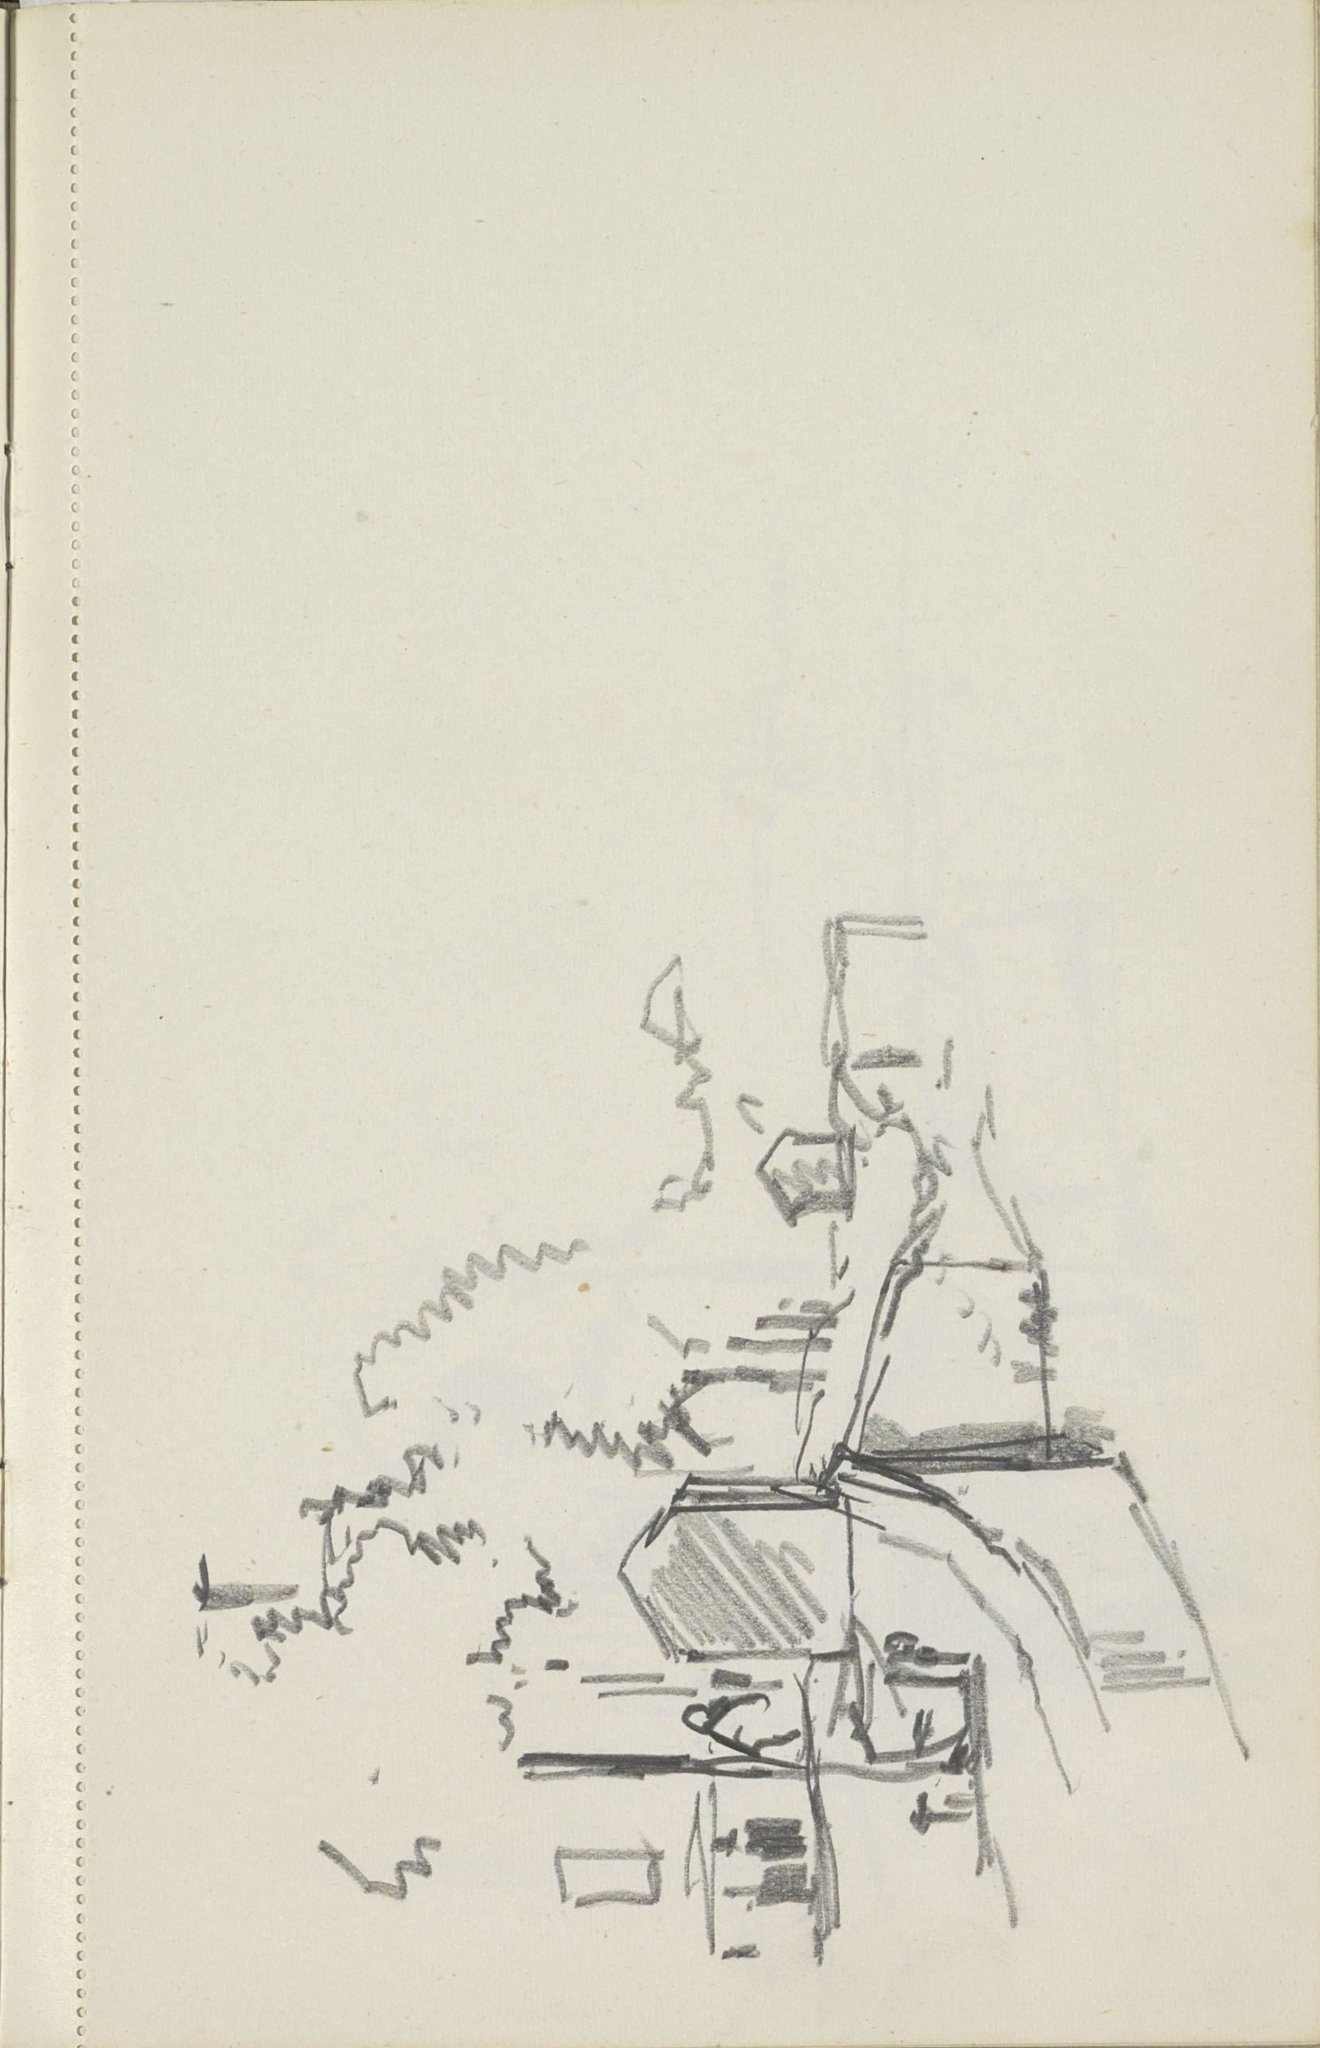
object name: sketchbook leaf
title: Kade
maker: cornelis vreedenburgh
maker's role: draughtsman, print maker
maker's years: 1880-1946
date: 1890-1946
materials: paper, pencil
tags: quay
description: Blad 14 recto uit een schetsboek met 50 bladen.